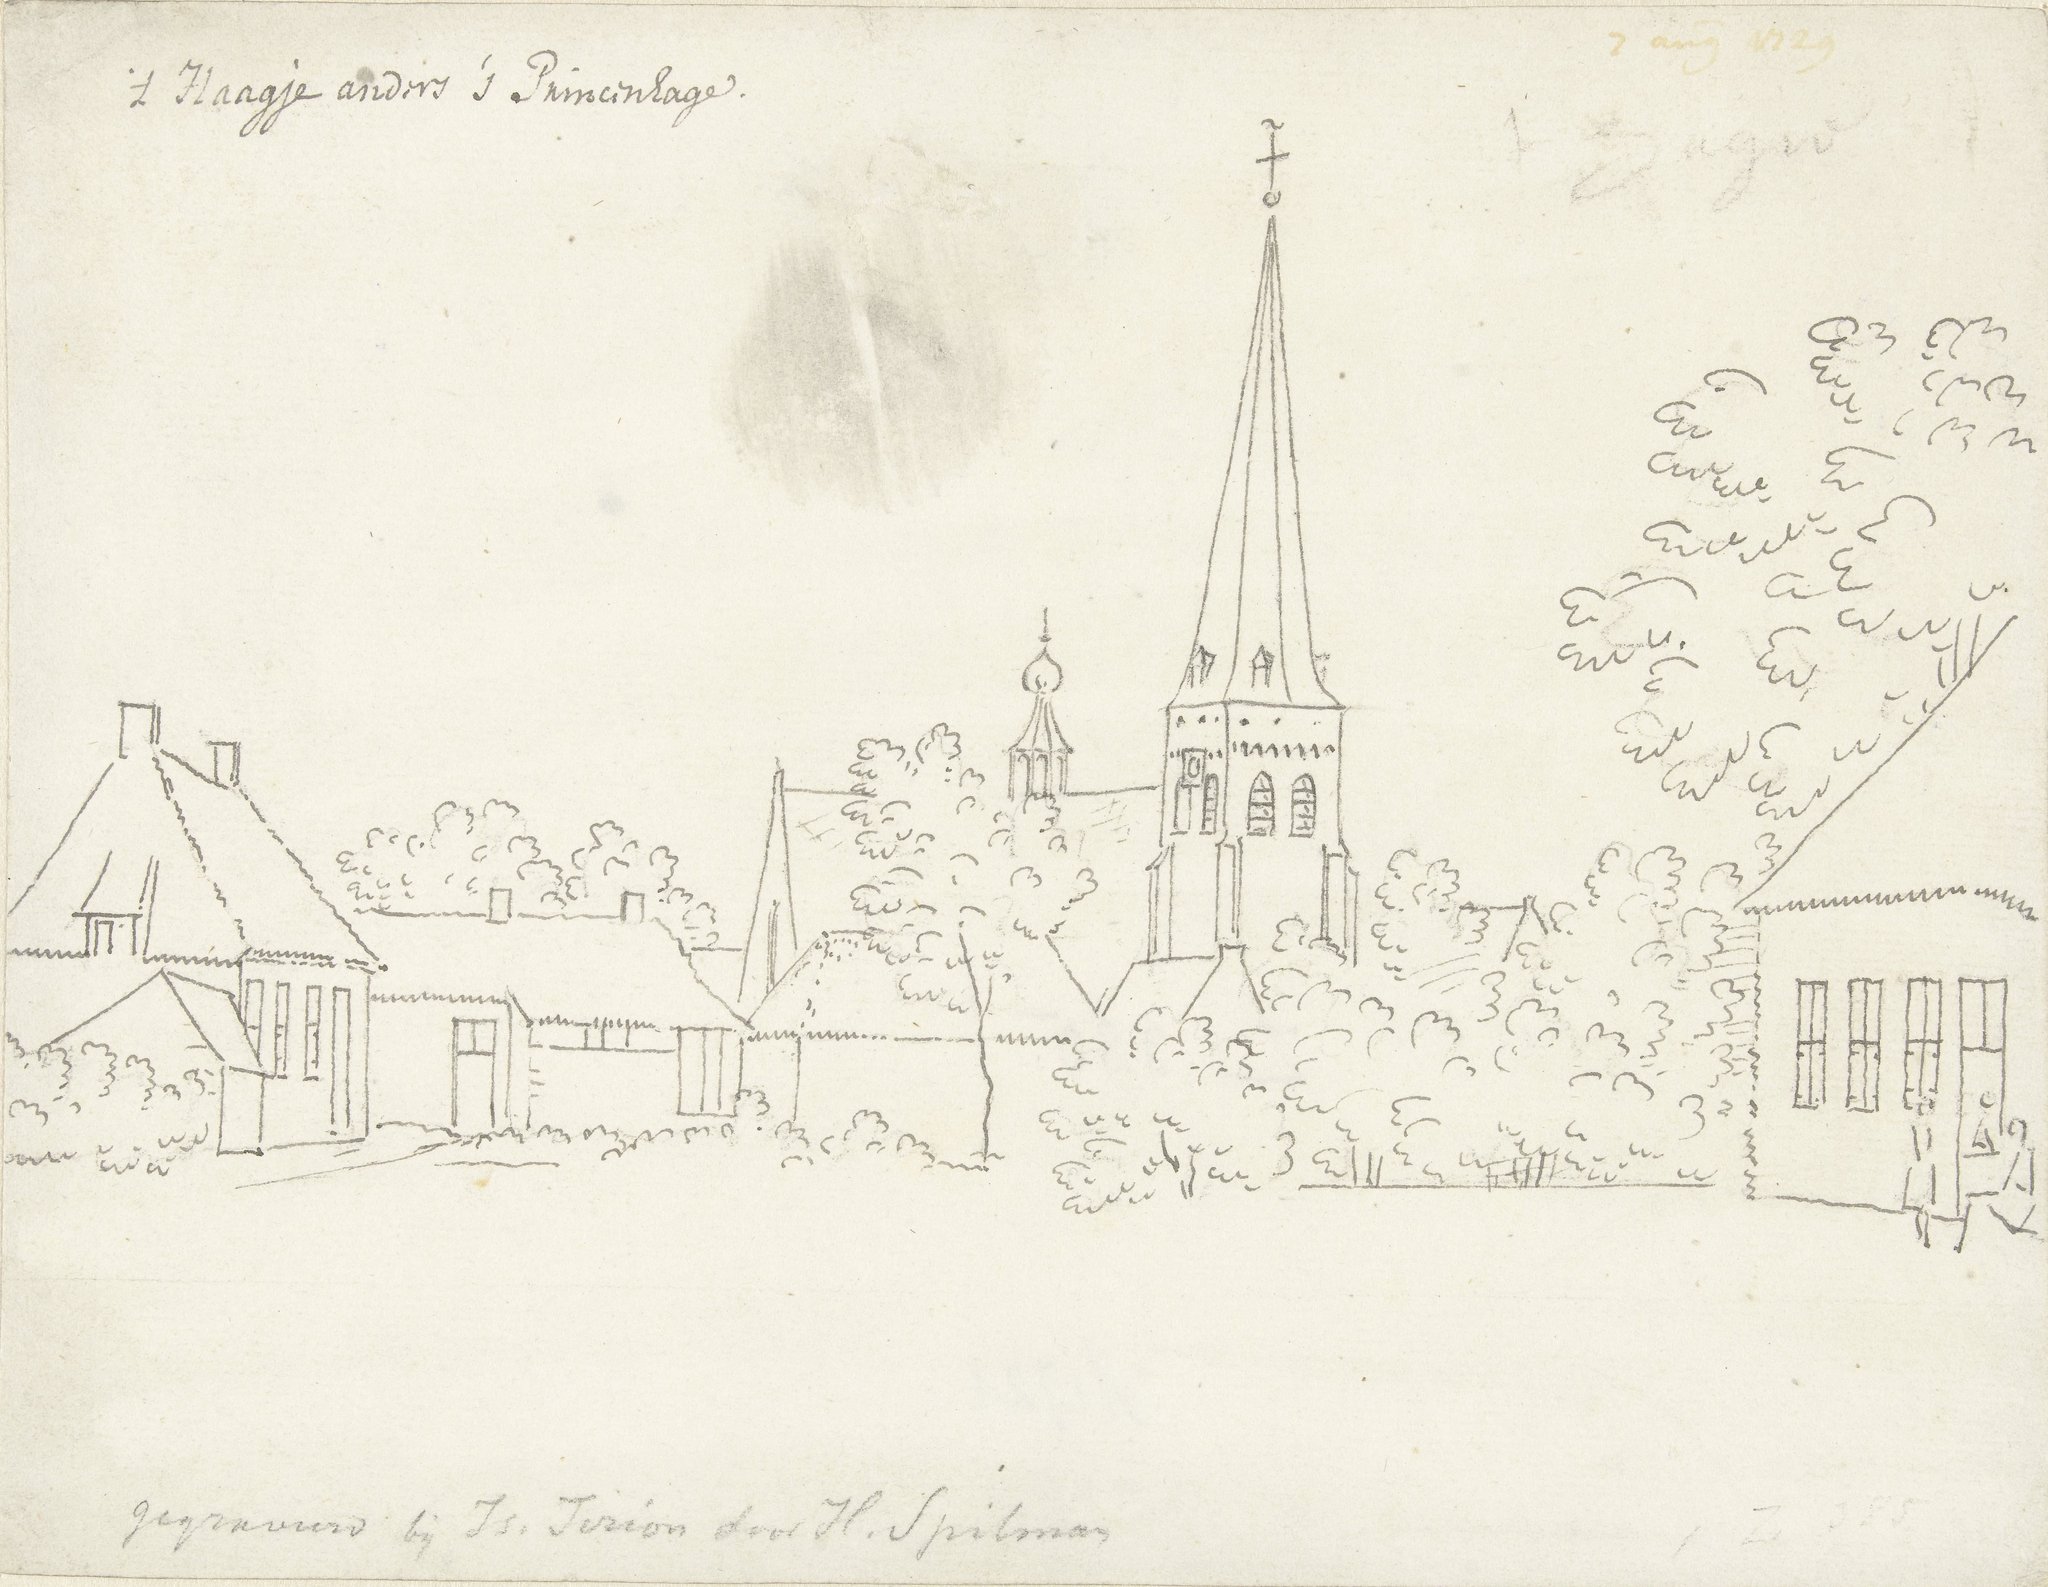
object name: drawing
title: Princenhage, bij Breda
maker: cornelis pronk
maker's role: draughtsman, painter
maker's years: 1691-1759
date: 1729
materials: ink, paper, pencil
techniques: pen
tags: prospect of village, silhouette of village, church (exterior)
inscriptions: inscription: ‘'t Haagje anders 's Princenhage / 7 aug 1729 / 't hagie’, inscription: ‘gegraveerd by Is. Tirion door H. Spilman’